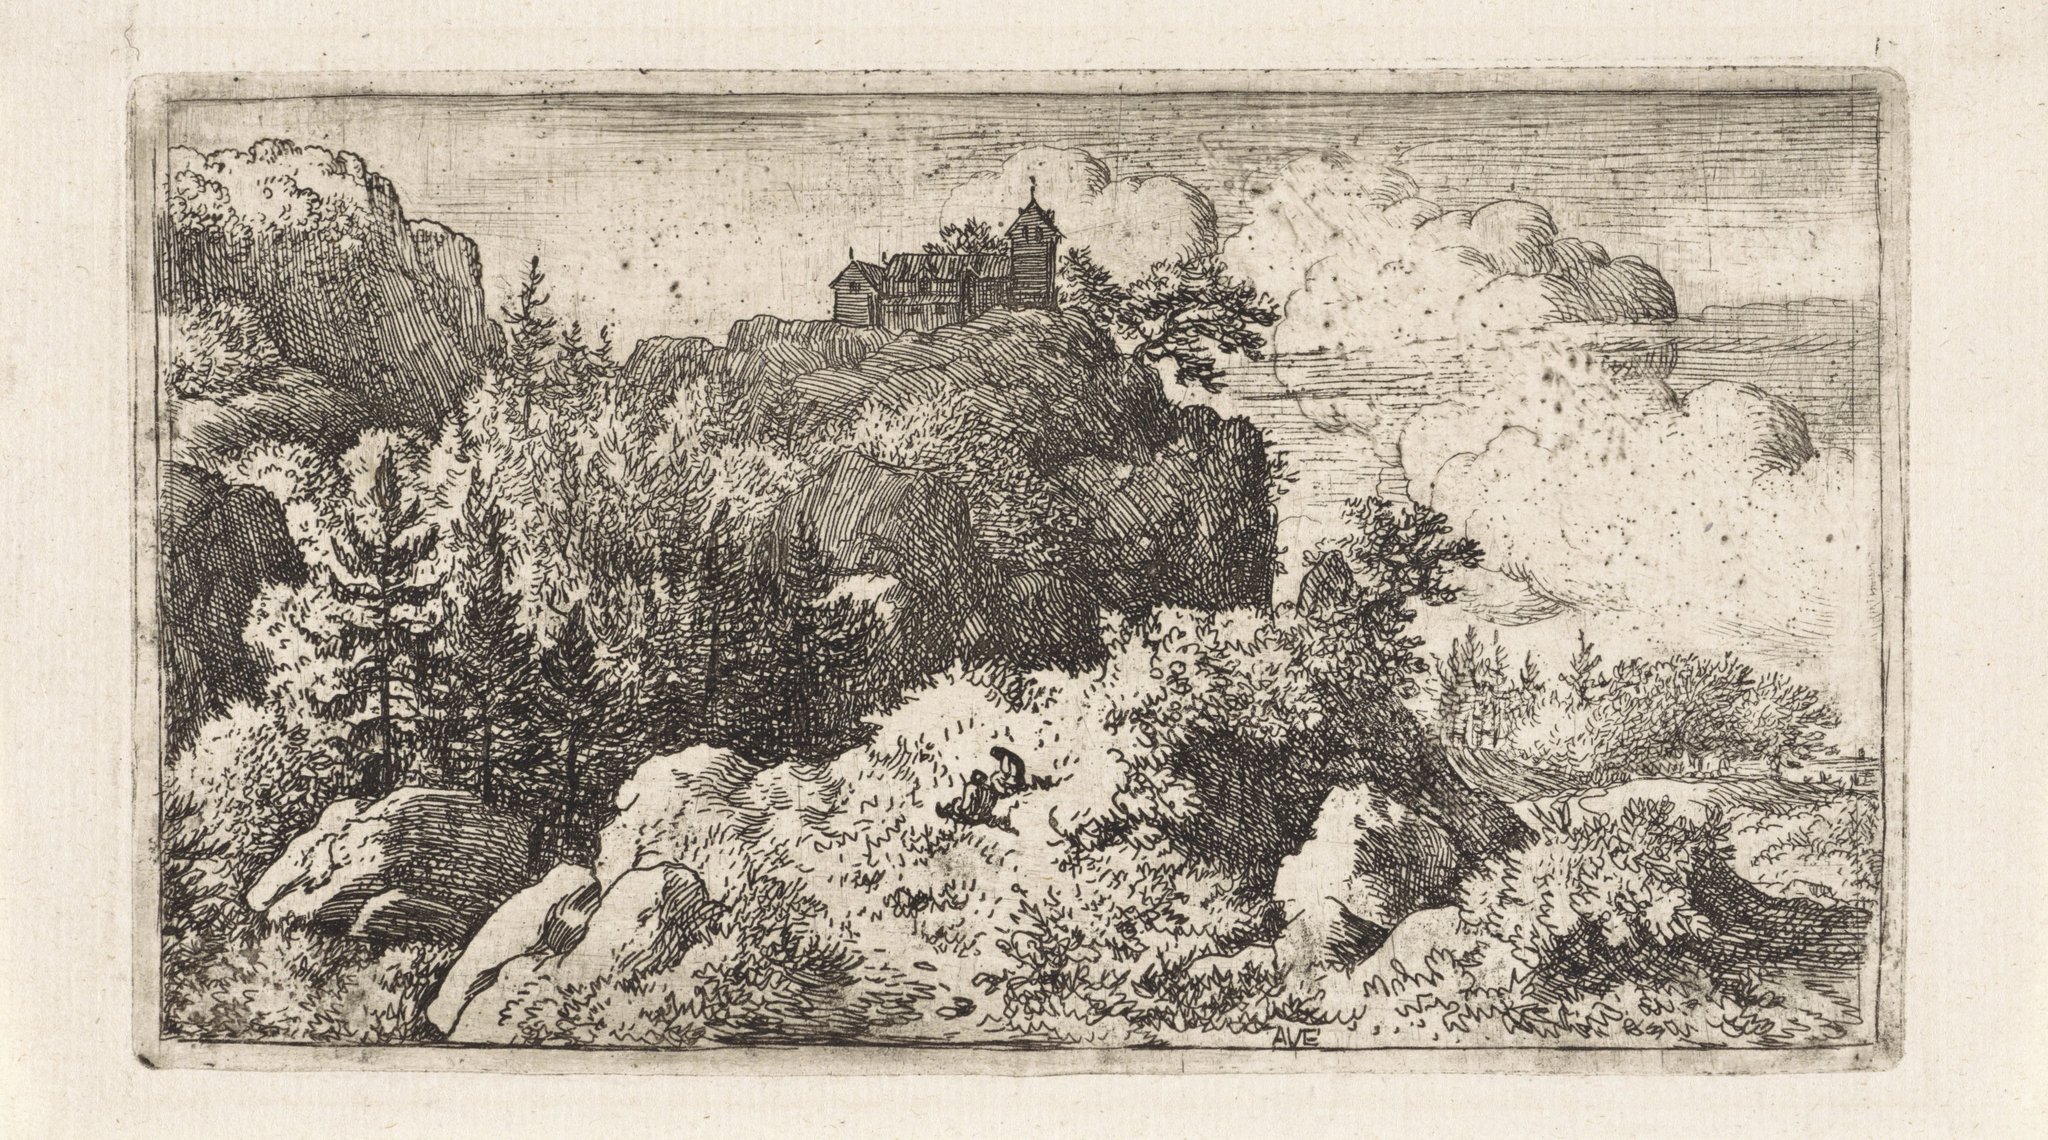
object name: print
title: Naaldbomen in een nauwe doorgang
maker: allaert van everdingen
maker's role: draughtsman, painter, print maker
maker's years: 1621-1675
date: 1631-1675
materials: paper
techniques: etching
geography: netherlands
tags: mountains (+ landscape with figures, staffage)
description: Landschap met bergen en naaldbomen. Op de bergtop een gebouw met een toren en op helling op de voorgrond twee personen in het gras.